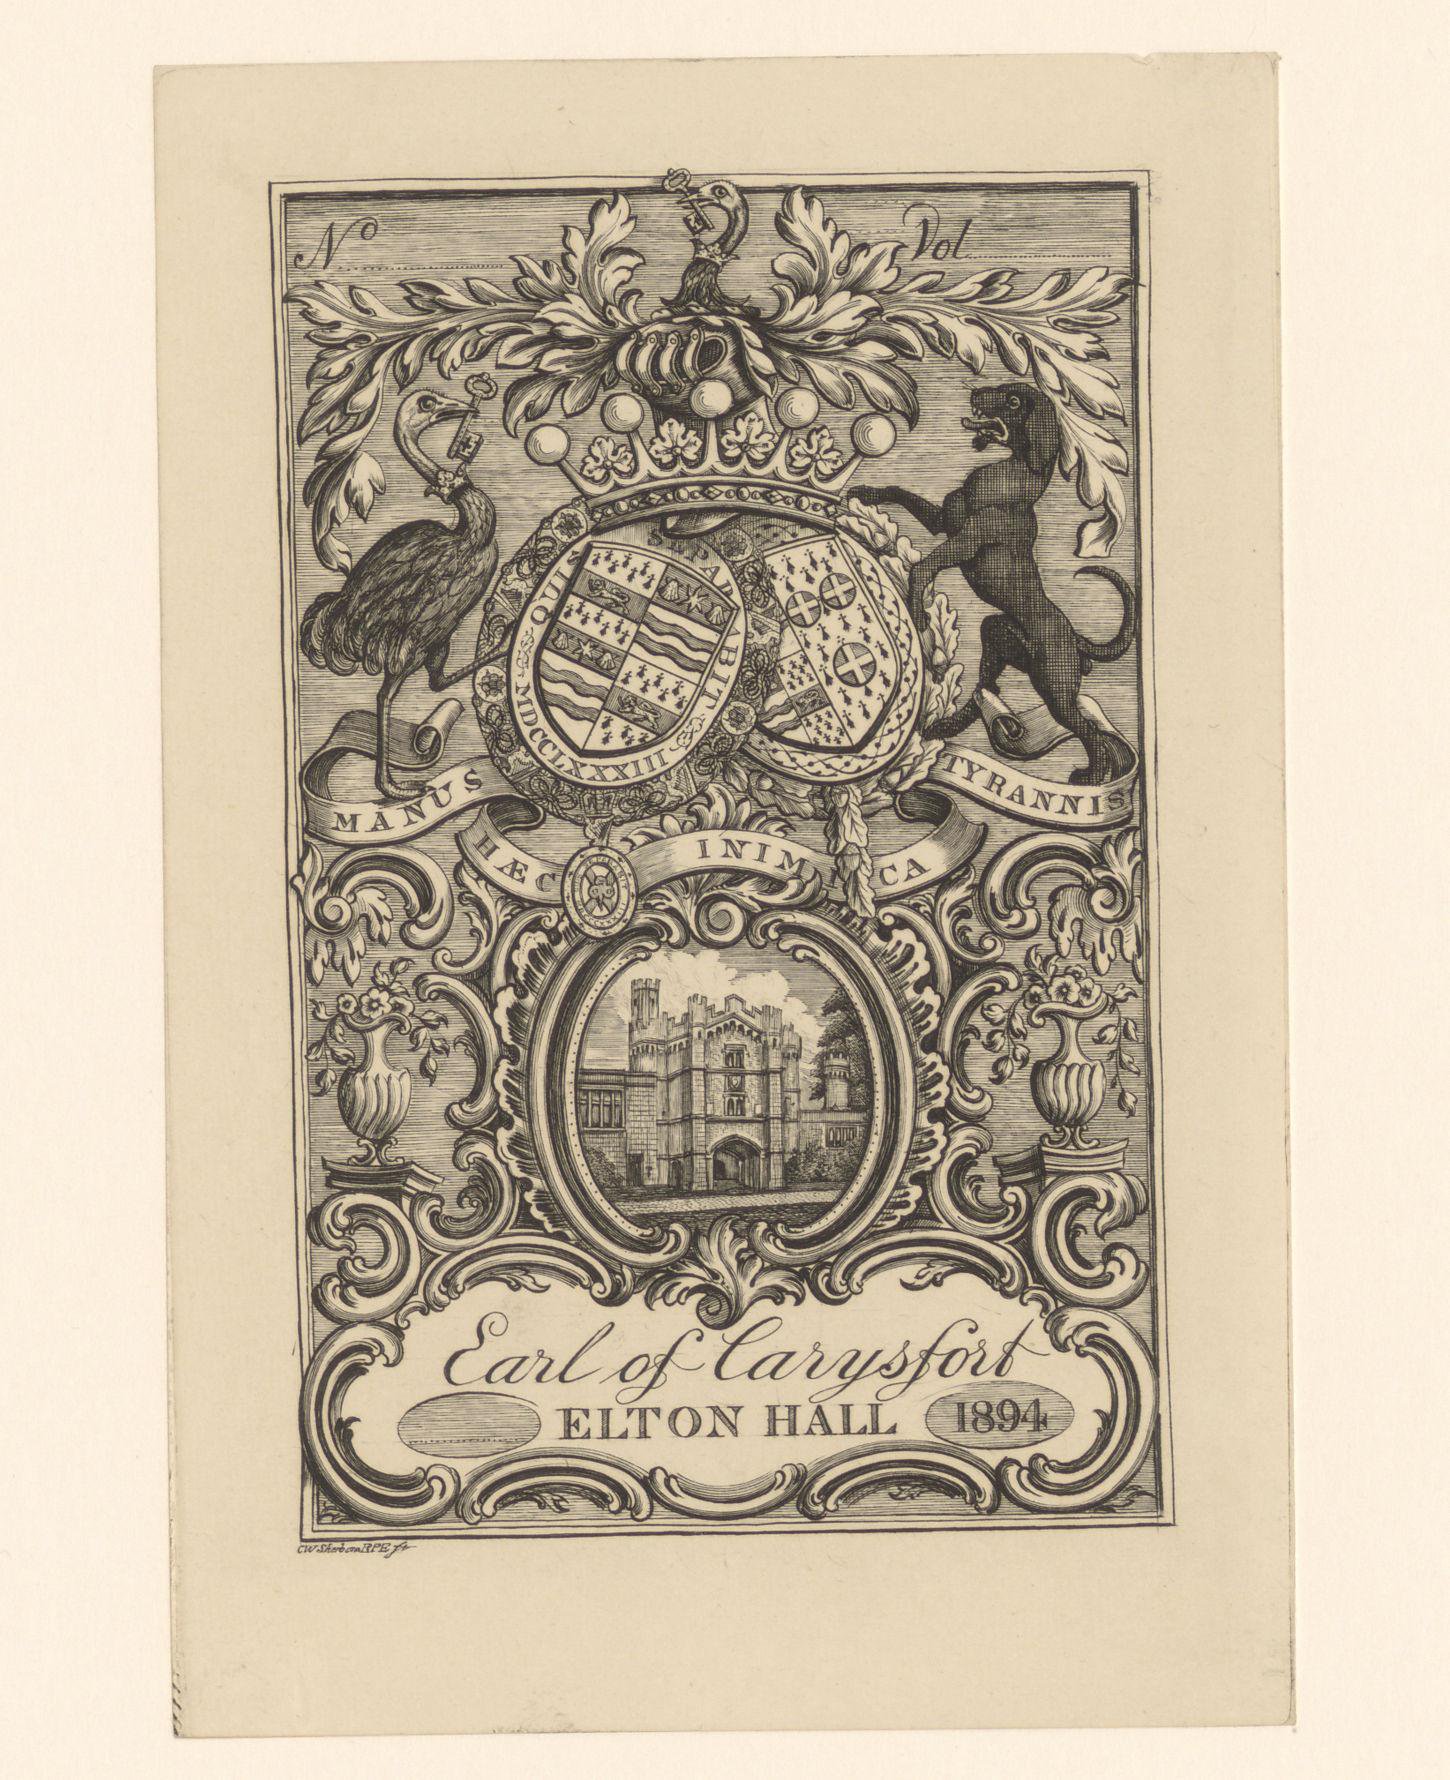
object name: bookplate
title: Manus haec inimica tyrannis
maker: charles william sherborn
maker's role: print maker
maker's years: 1831-1912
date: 1894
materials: paper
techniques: engraving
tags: politician, foliage ~ ornament, rural housing, e.g. country-house, villa, cottage, armorial bearing, heraldry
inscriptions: collector's mark: Lugt 2228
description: Tekst in het Latijn in de banier. Gezicht op de entree van Elton Hall in Cambridgeshire.